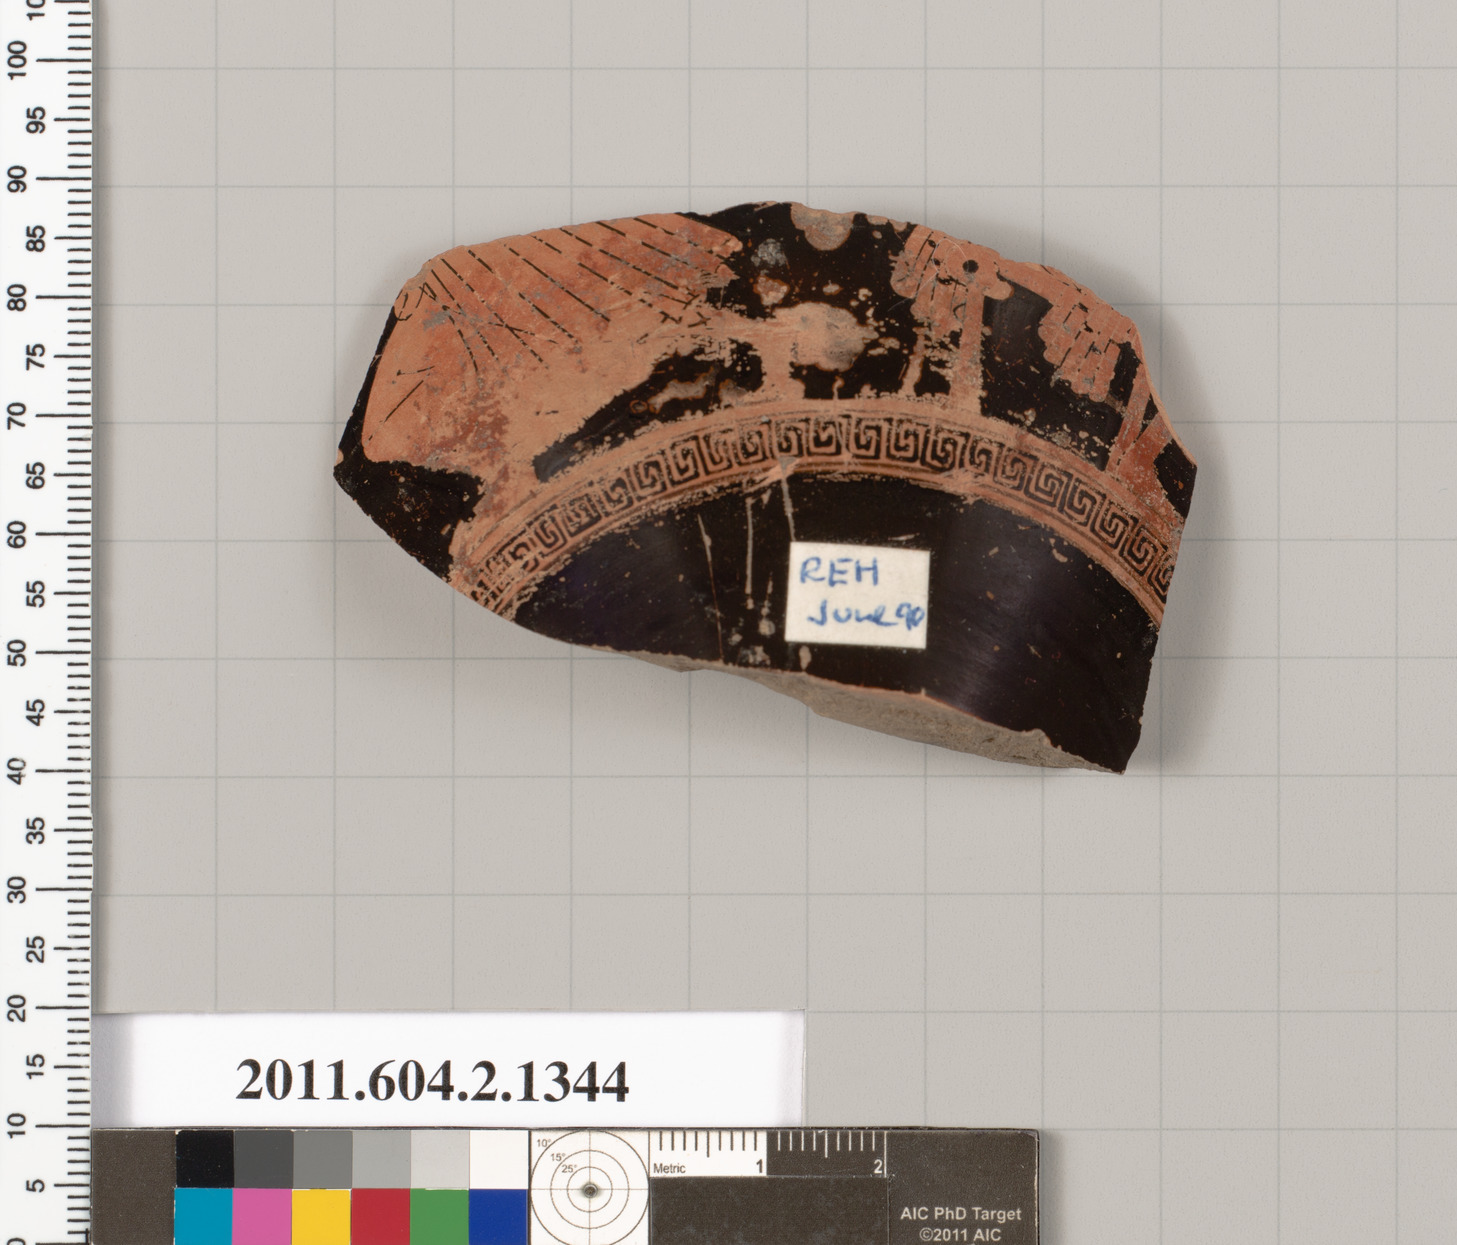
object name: skyphos fragment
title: Terracotta fragment of a skyphos (deep drinking cup)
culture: greek, attic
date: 475-451 BCE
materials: terracotta